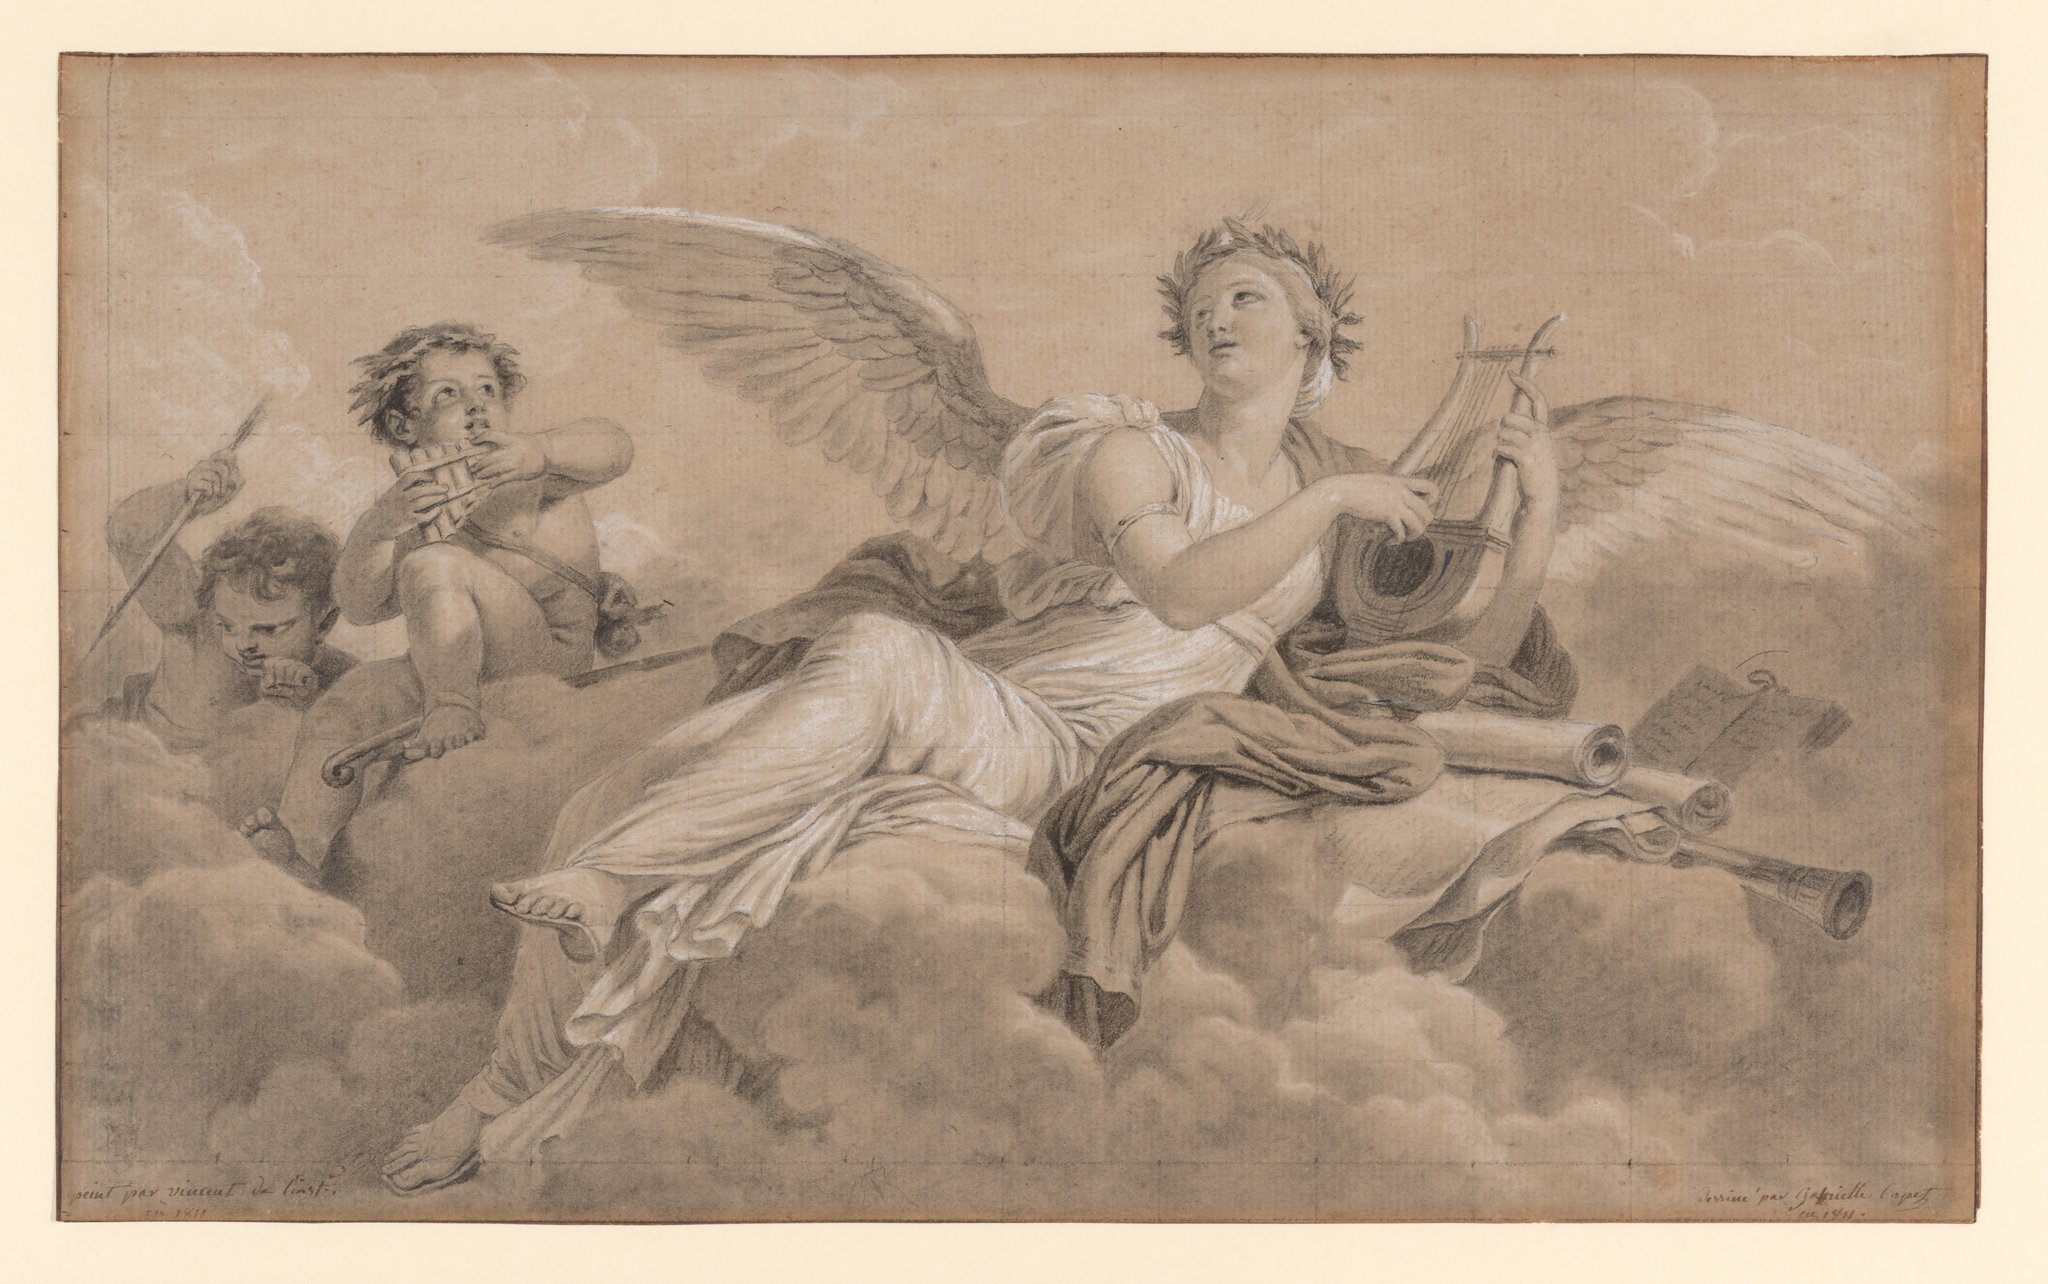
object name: drawing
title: An Allegory of Lyric Poetry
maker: marie gabrielle capet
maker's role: artist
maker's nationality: french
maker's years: 1761-1818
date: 1811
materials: chalk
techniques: heightening, drawing, stumping